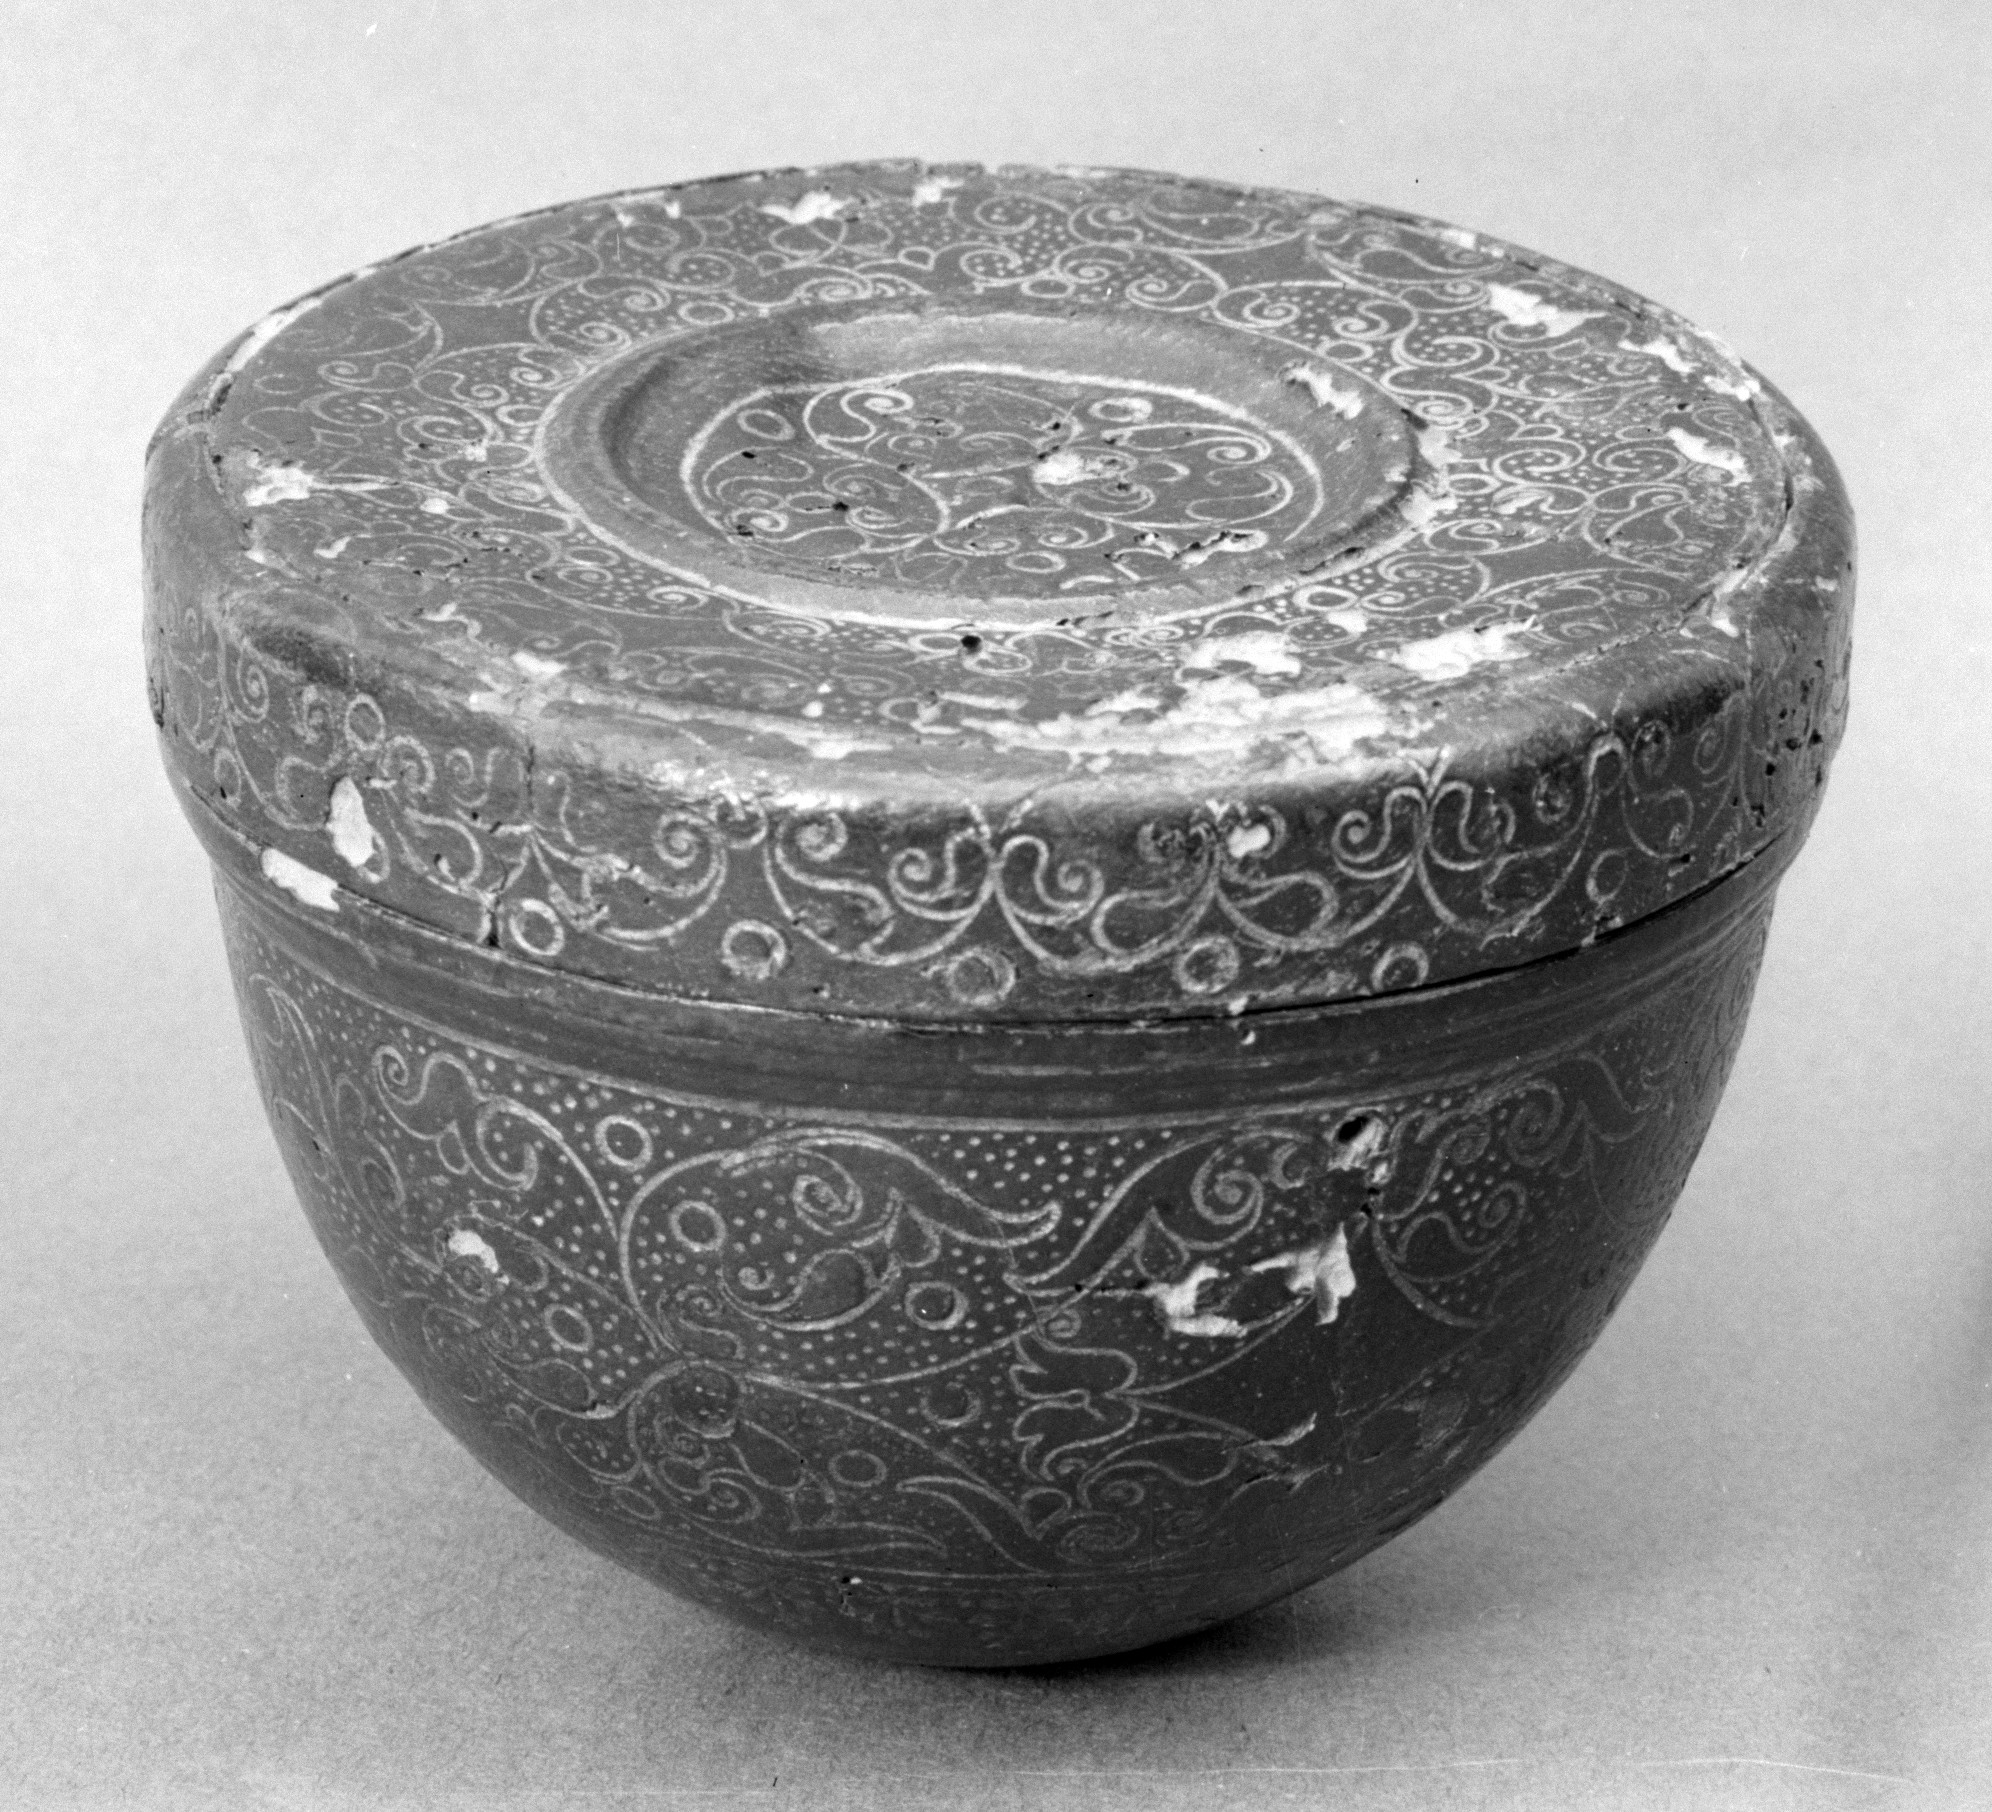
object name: cup case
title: Coconut cup case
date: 1503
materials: gilt, leather, velvet